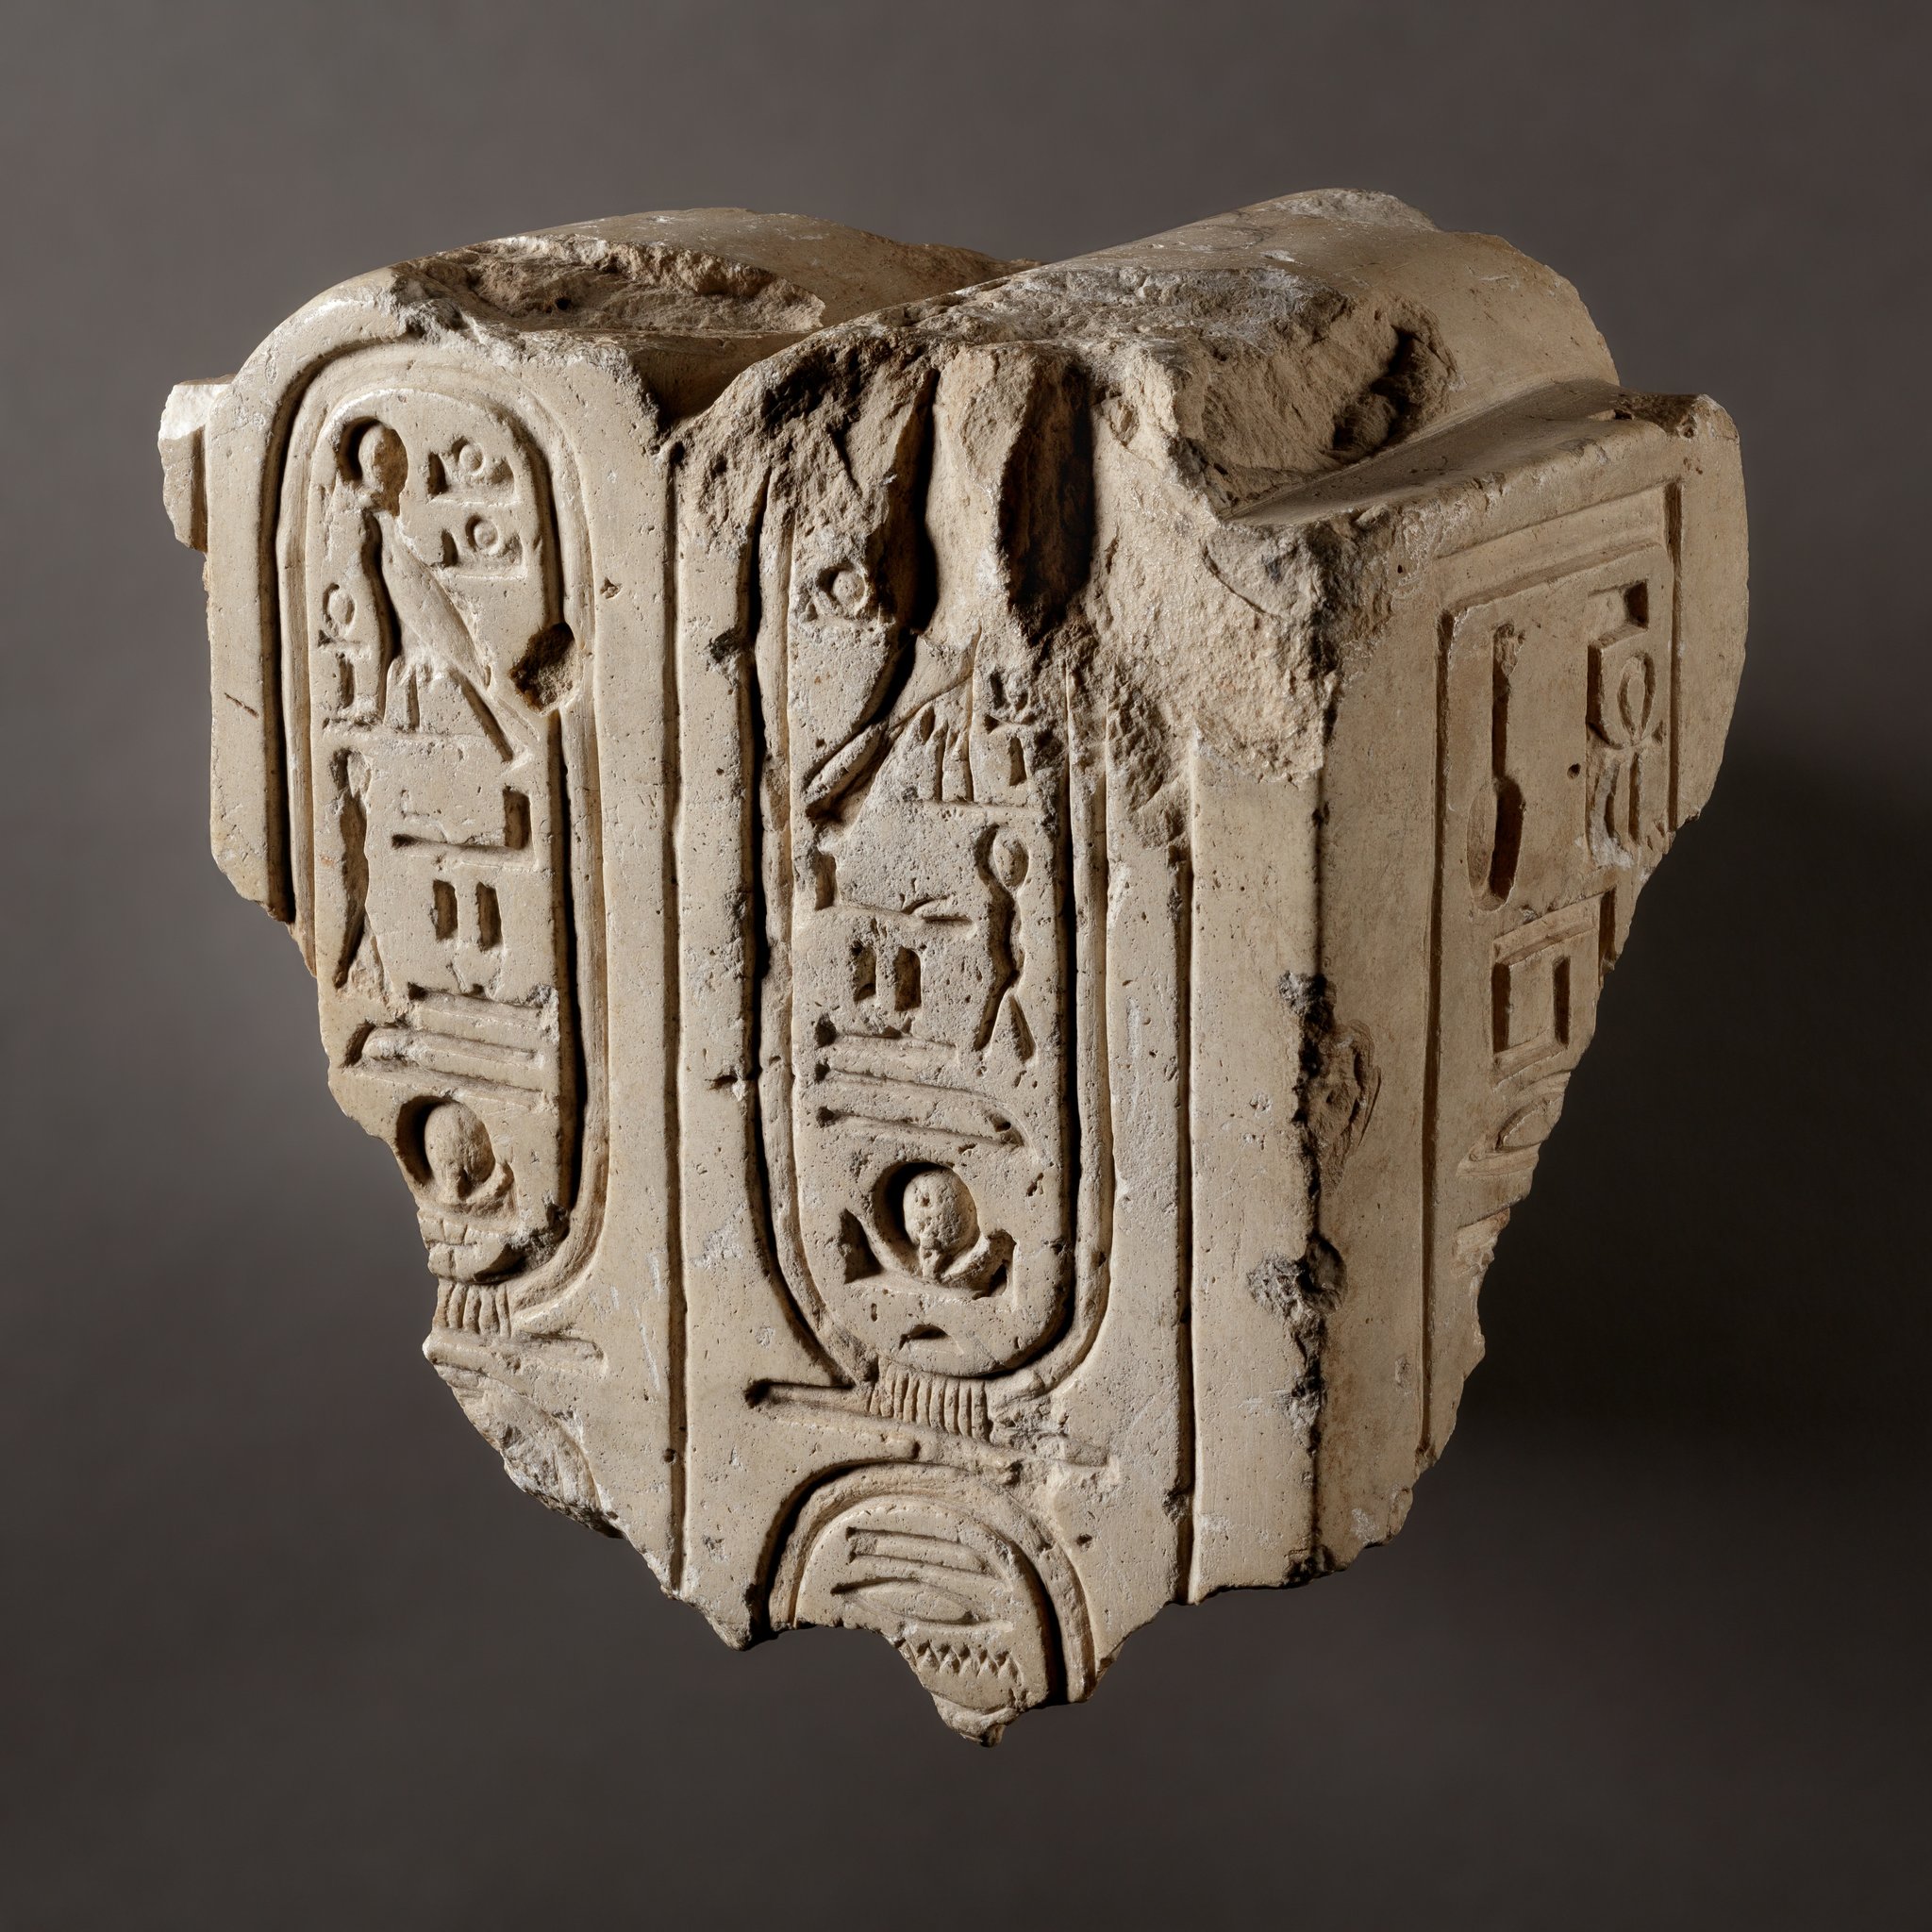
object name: terminal post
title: Upper end of terminal post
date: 1352-1336 BCE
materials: limestone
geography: egypt